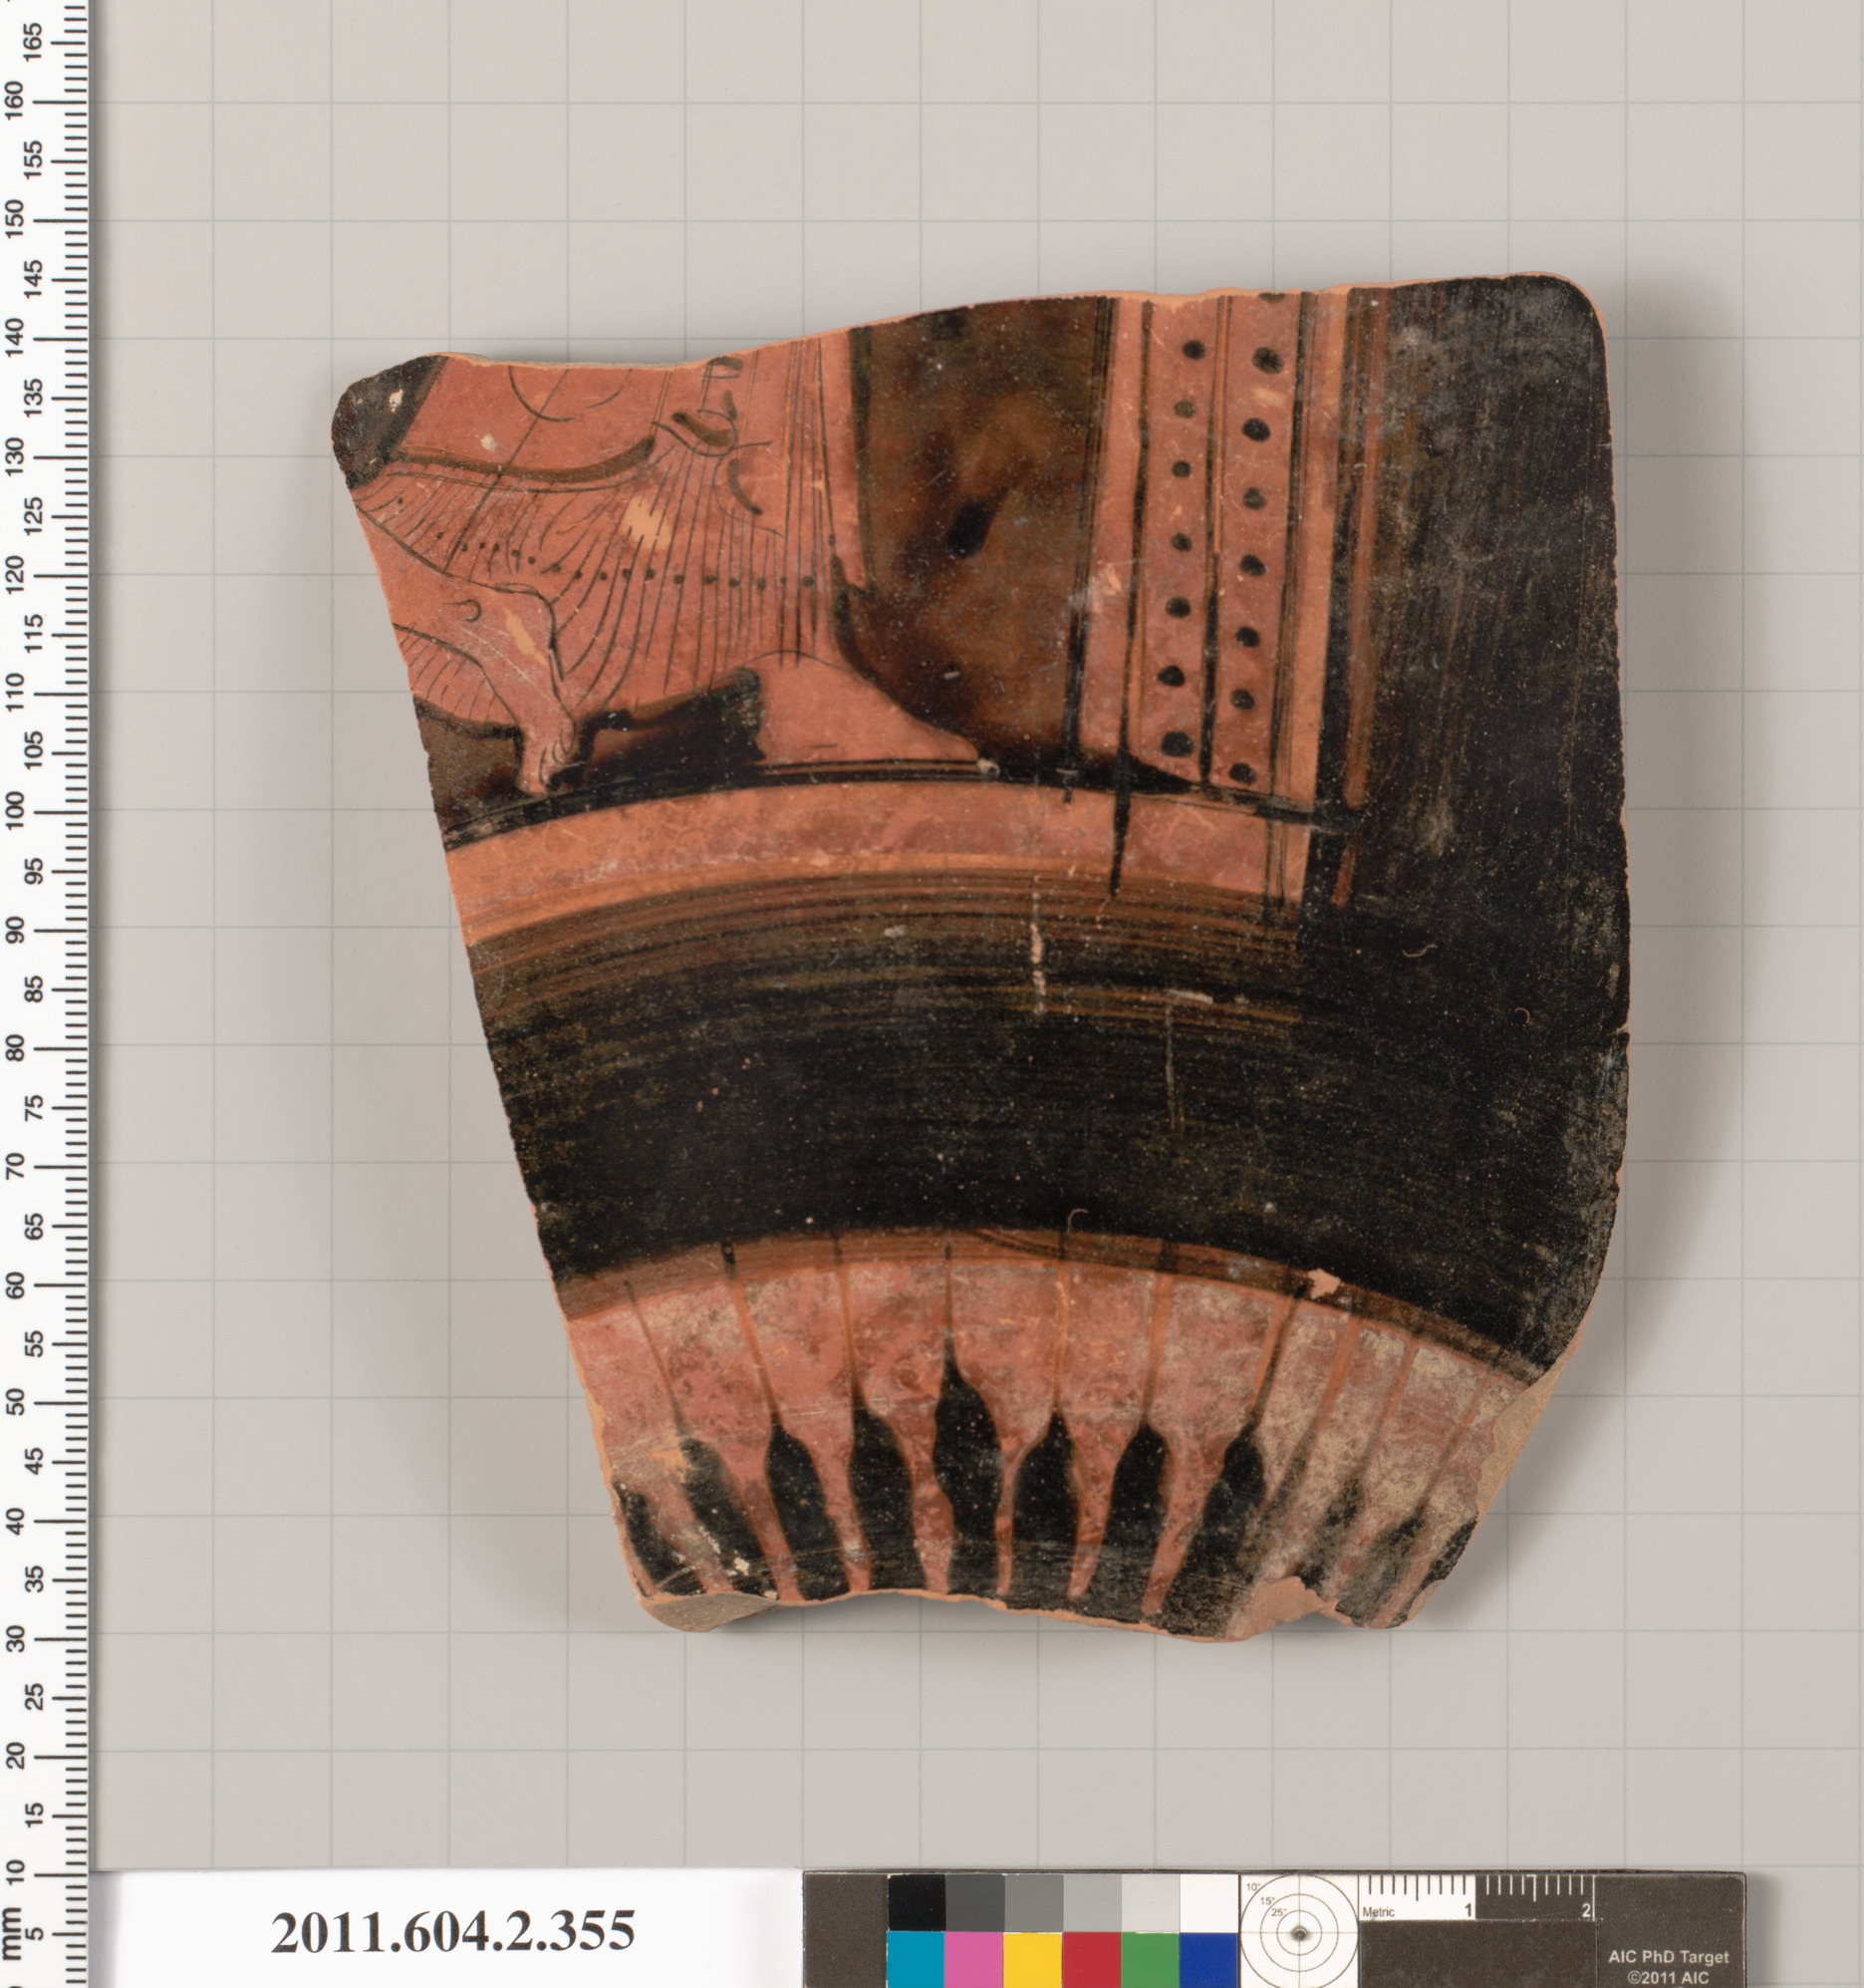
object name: column krater fragment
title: Terracotta fragment of a column-krater (bowl for mixing wine and water)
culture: greek, attic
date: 460-440 BCE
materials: terracotta